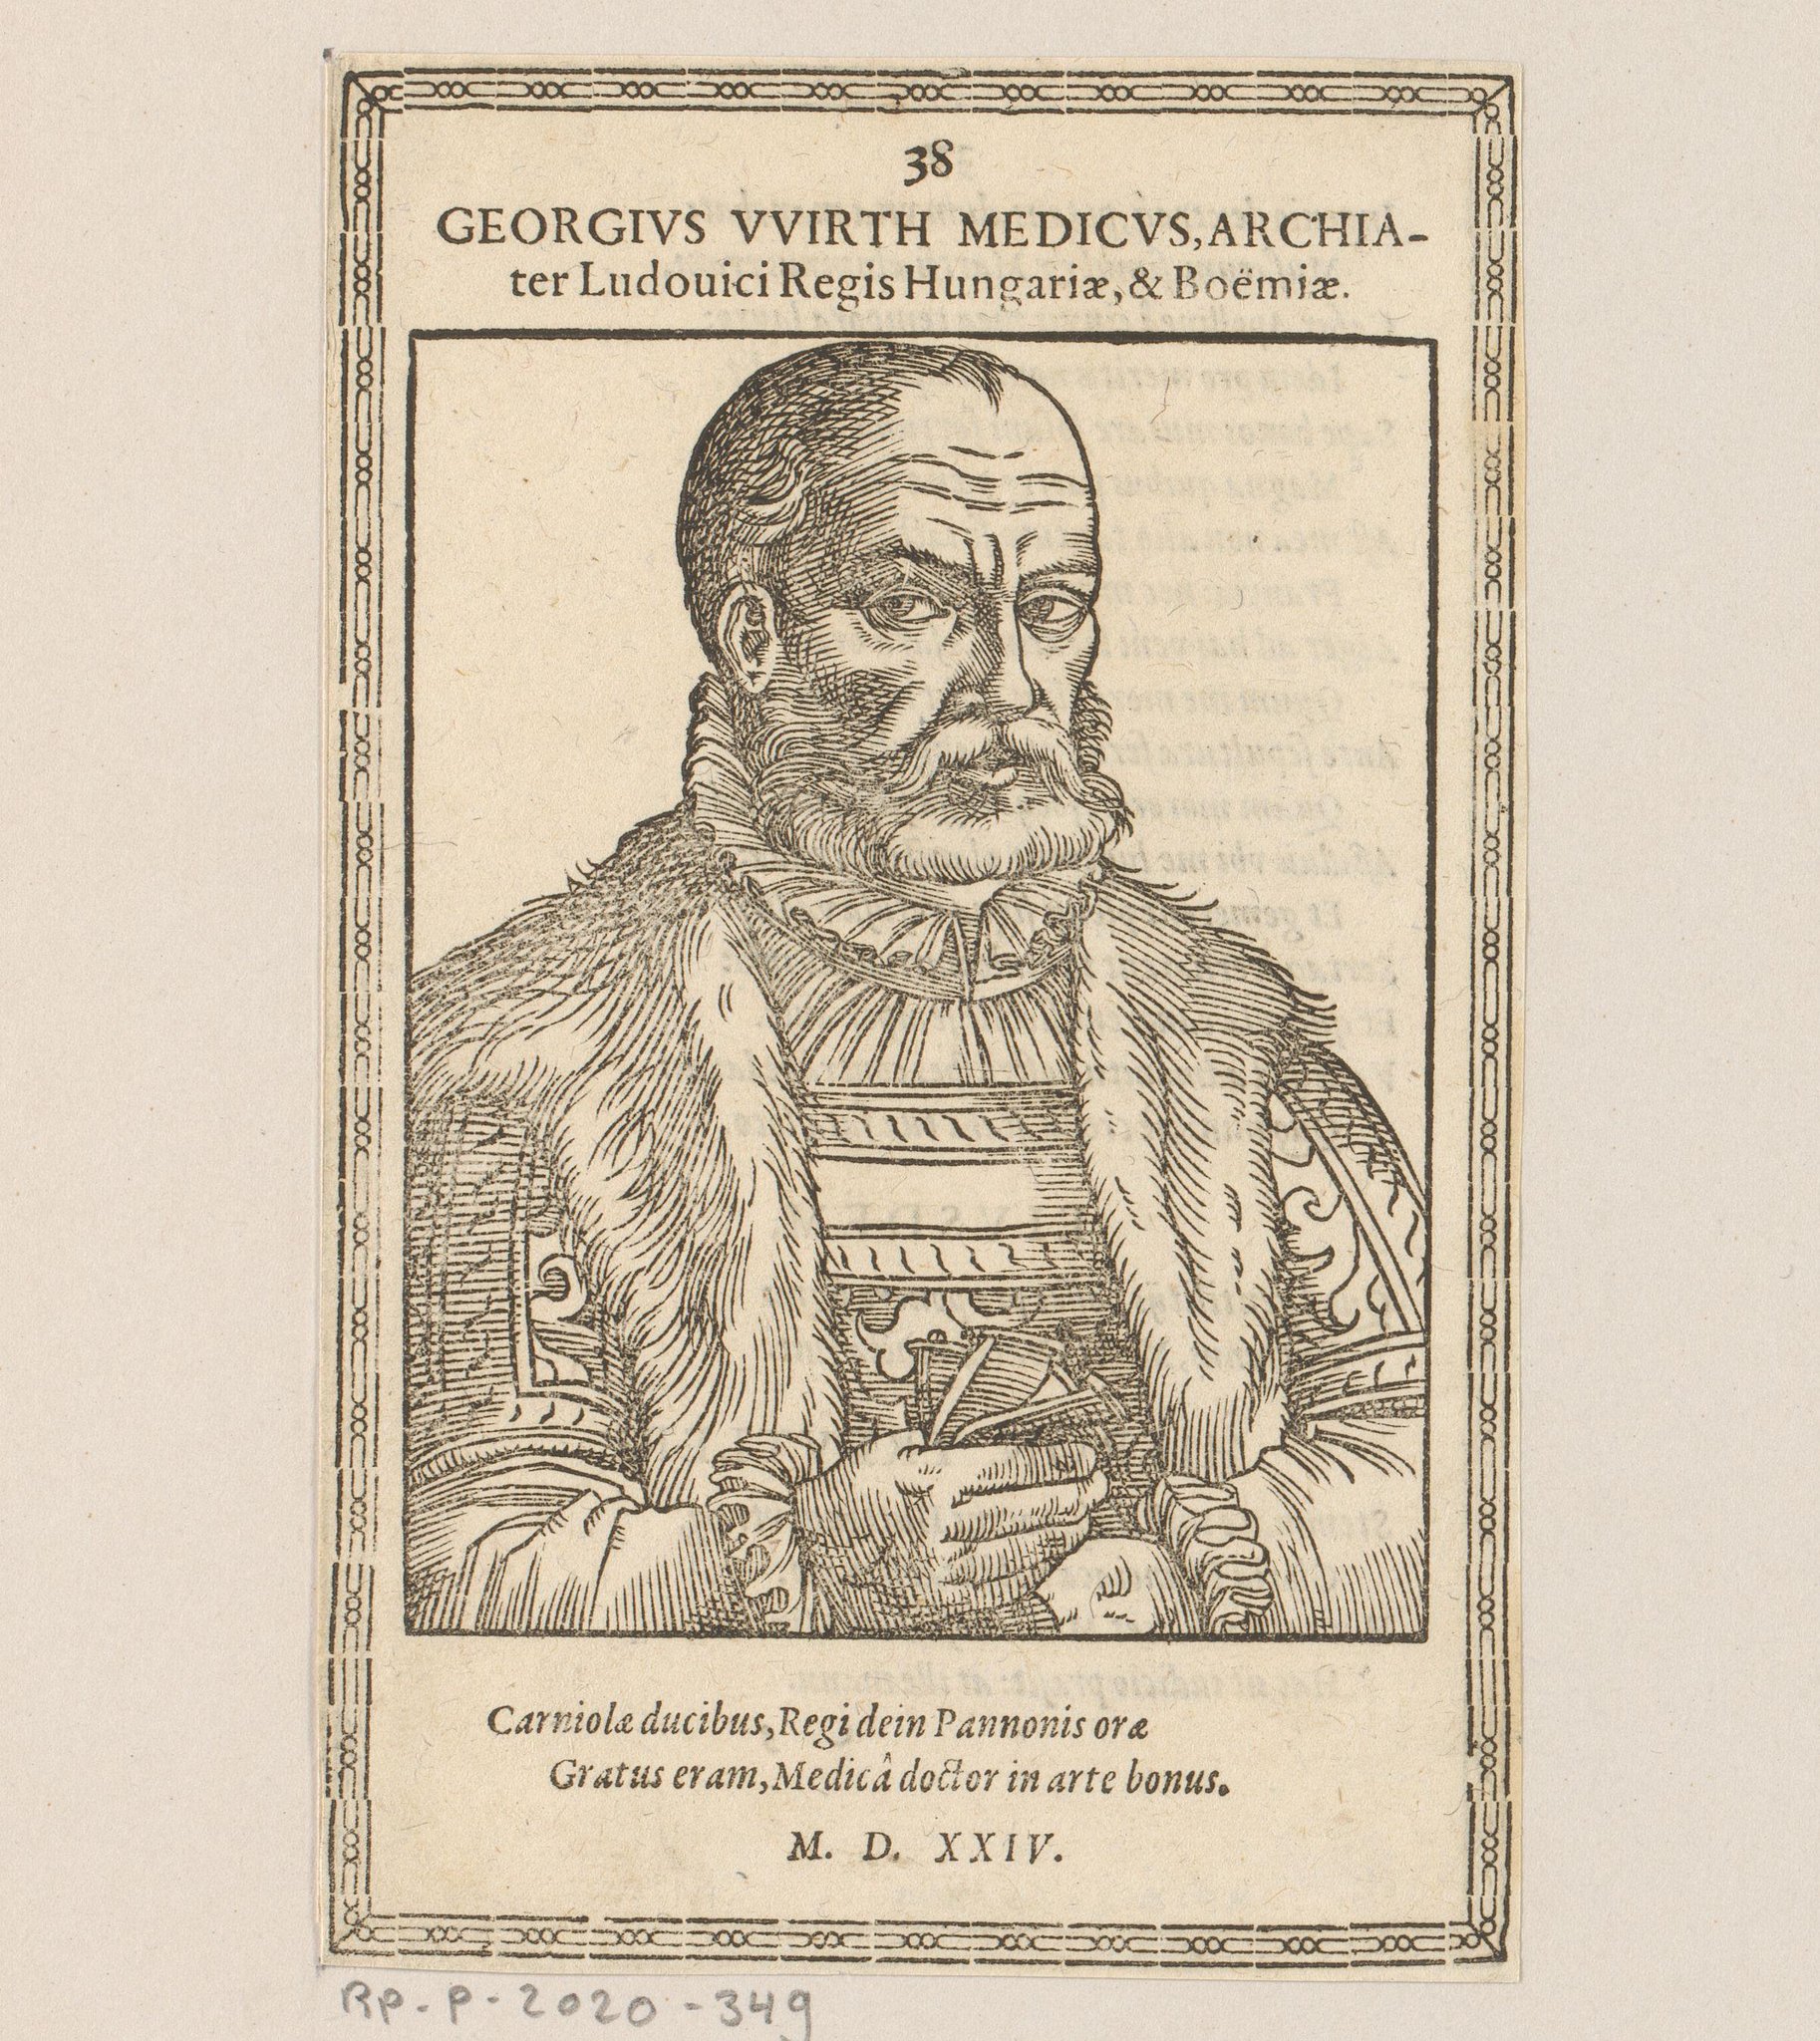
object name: book illustration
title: Portret van Georg Wirth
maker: bernhard jobin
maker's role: printer, publisher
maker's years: 1545-1593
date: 1590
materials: paper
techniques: letterpress printing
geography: straatsburg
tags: historical persons, physician, doctor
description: Prent uit: Reusner, Nikolaus. Icones sive imagines virorum literis illustrium (...). Straatsburg: Bernhard Jobin, 1590, p. 38. Prent voor het eerst verschenen in de eerste editie van 1587. Prent ook gebruikt in latere publicaties.